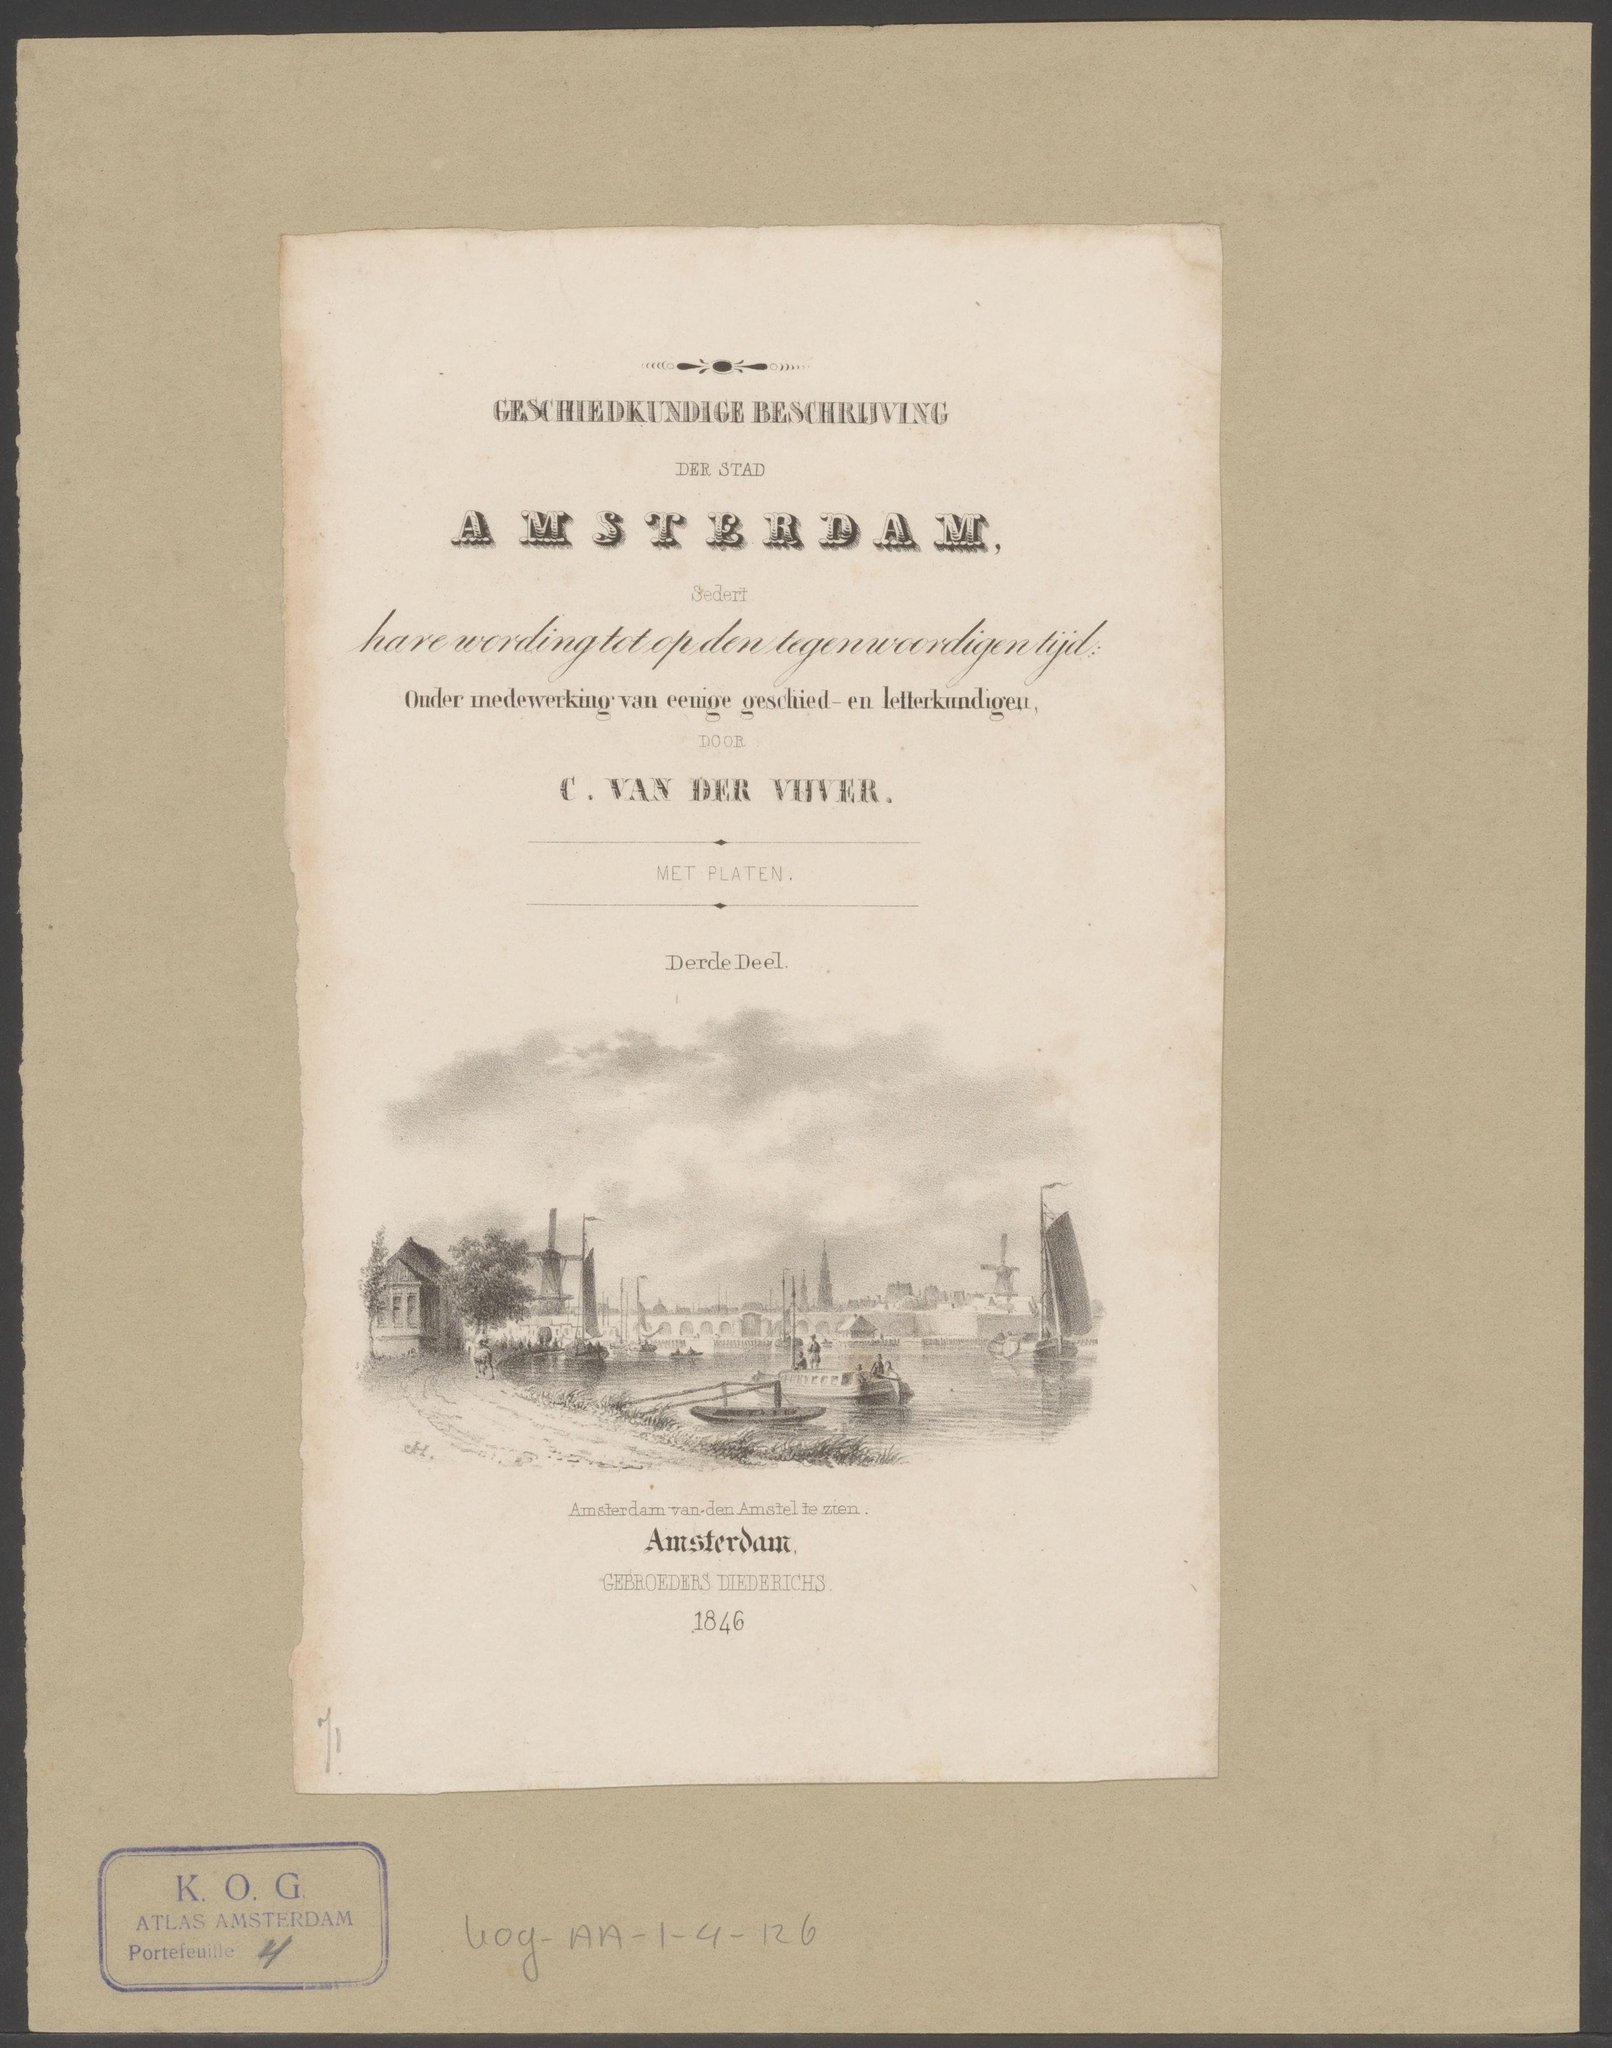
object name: print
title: Titelpagina voor: Cornelis van der Vijver, Geschiedkundige beschrijving der stad Amsterdam (...), 1846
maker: Anonymous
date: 1846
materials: paper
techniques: lithograph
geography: amsterdam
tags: sailing-ship, sailing-boat, city-view in general; 'veduta', river, bridge in city across river, canal, etc., boat propelled by man or animal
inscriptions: collector's mark: ‘4’ Lugt 1641b, monogram: ‘cH’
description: Titelpagina voor: Vijver, Cornelis van der. Geschiedkundige beschrijving der stad Amsterdam (...). Amsterdam: Gebroeders Diederichs, 1846.